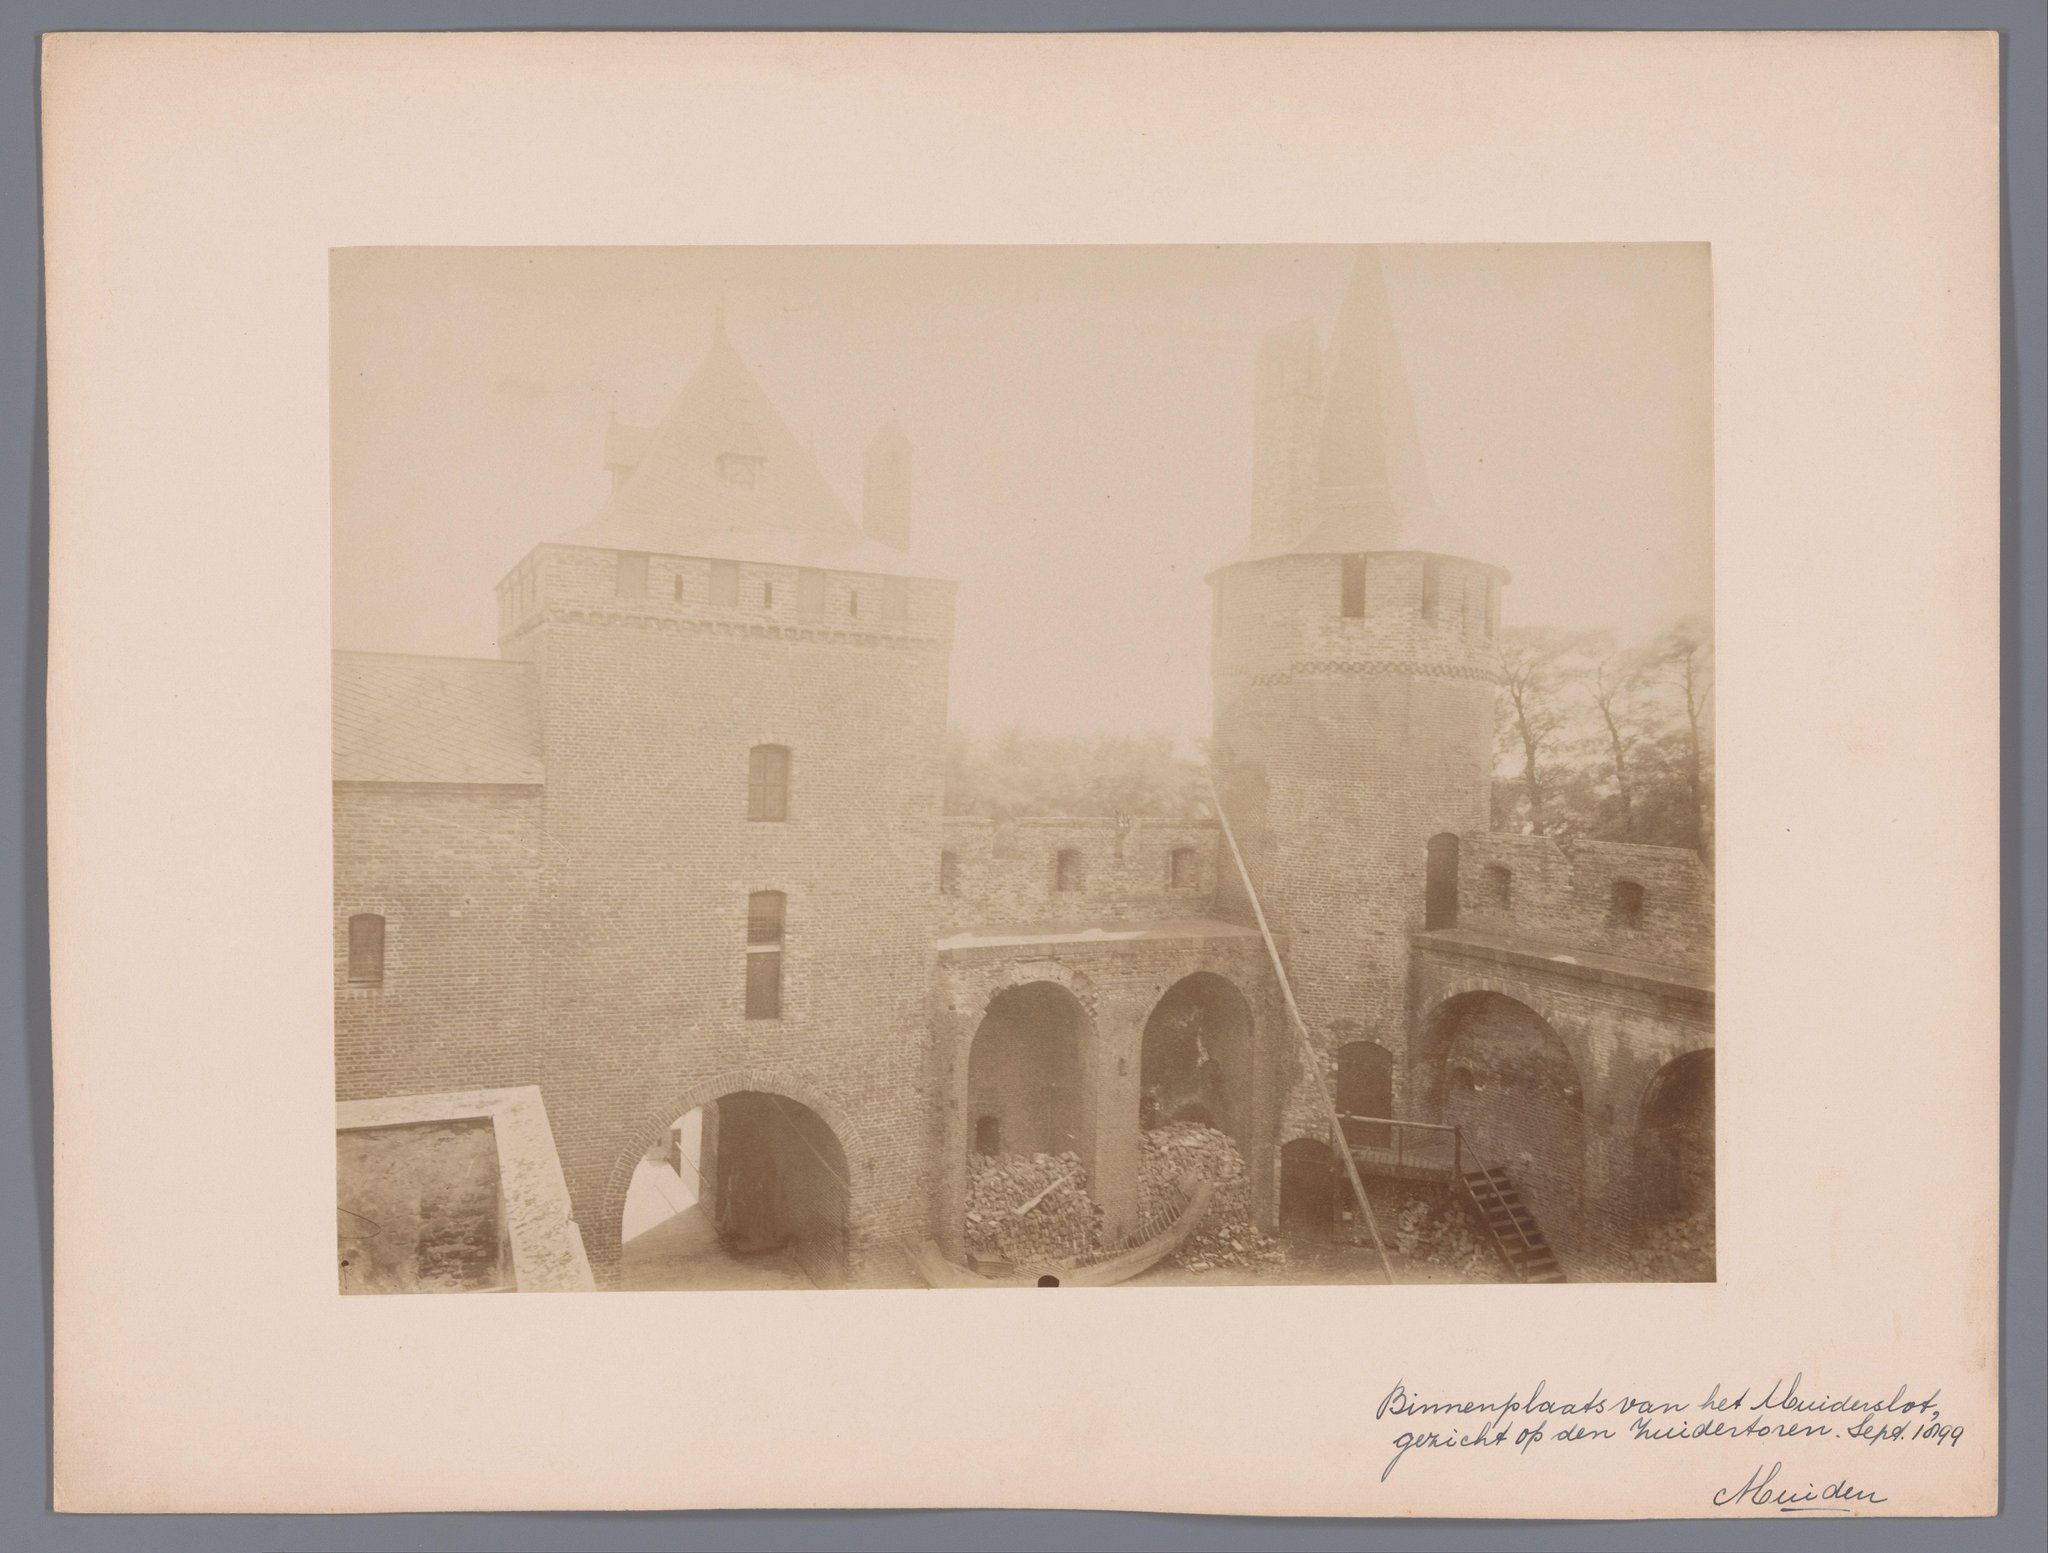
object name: photograph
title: Binnenplaats van het Muiderslot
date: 1899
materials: cardboard, photographic support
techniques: albumen print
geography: muiderslot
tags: castle, courtyard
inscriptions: annotation: ‘Binnenplaats van het slot te Muiden (N.H.) gezicht op den zuiertoren/ sept 1899/ negatieven Rijksdients Monumentenzorg’, annotation: ‘Binnenplaats van het Muiderslot, gezicht op den zuidertoren. Sept. 1899/ Muiden’